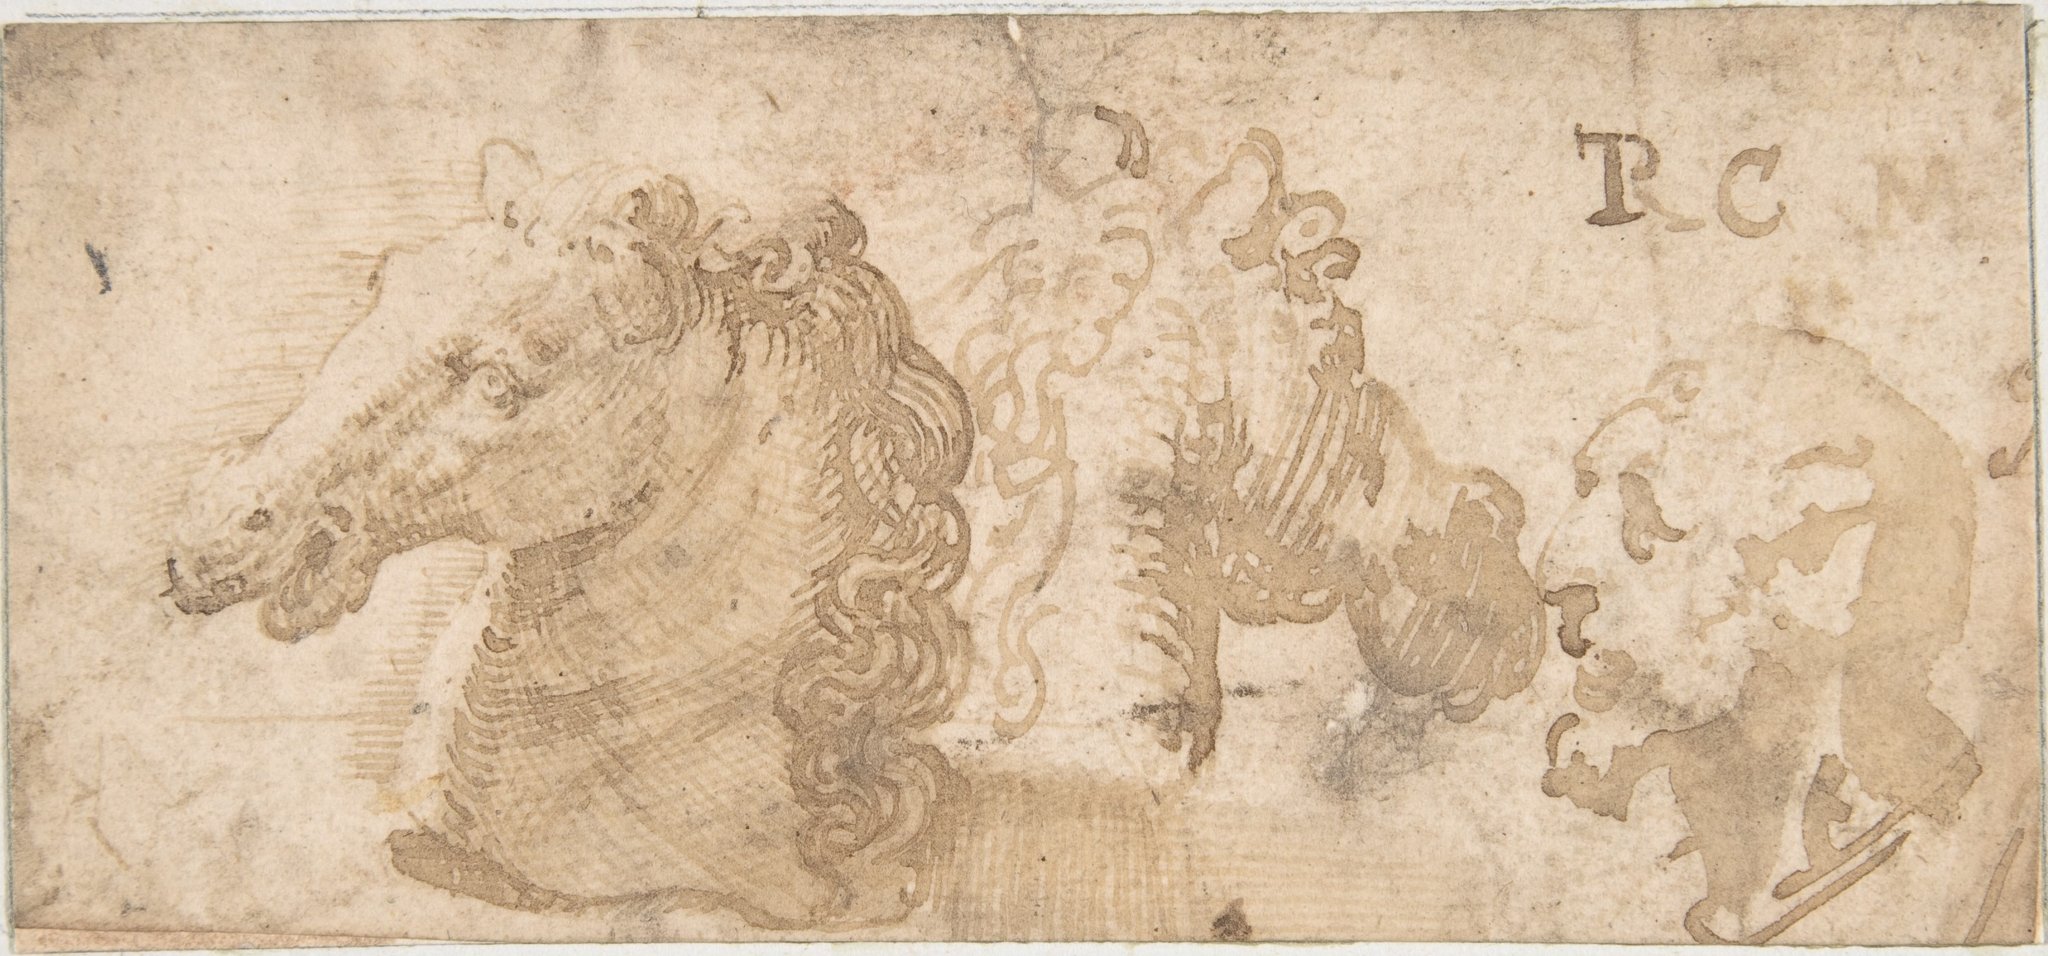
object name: drawing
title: Two Views of a Horse's Head; the Head of a Bearded Man in Profile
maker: anonymous, italian, 16th century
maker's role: artist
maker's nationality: italian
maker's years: 1500-1600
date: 1550-1600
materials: chalk, ink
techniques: brush, pen, wash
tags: men,profiles,horses